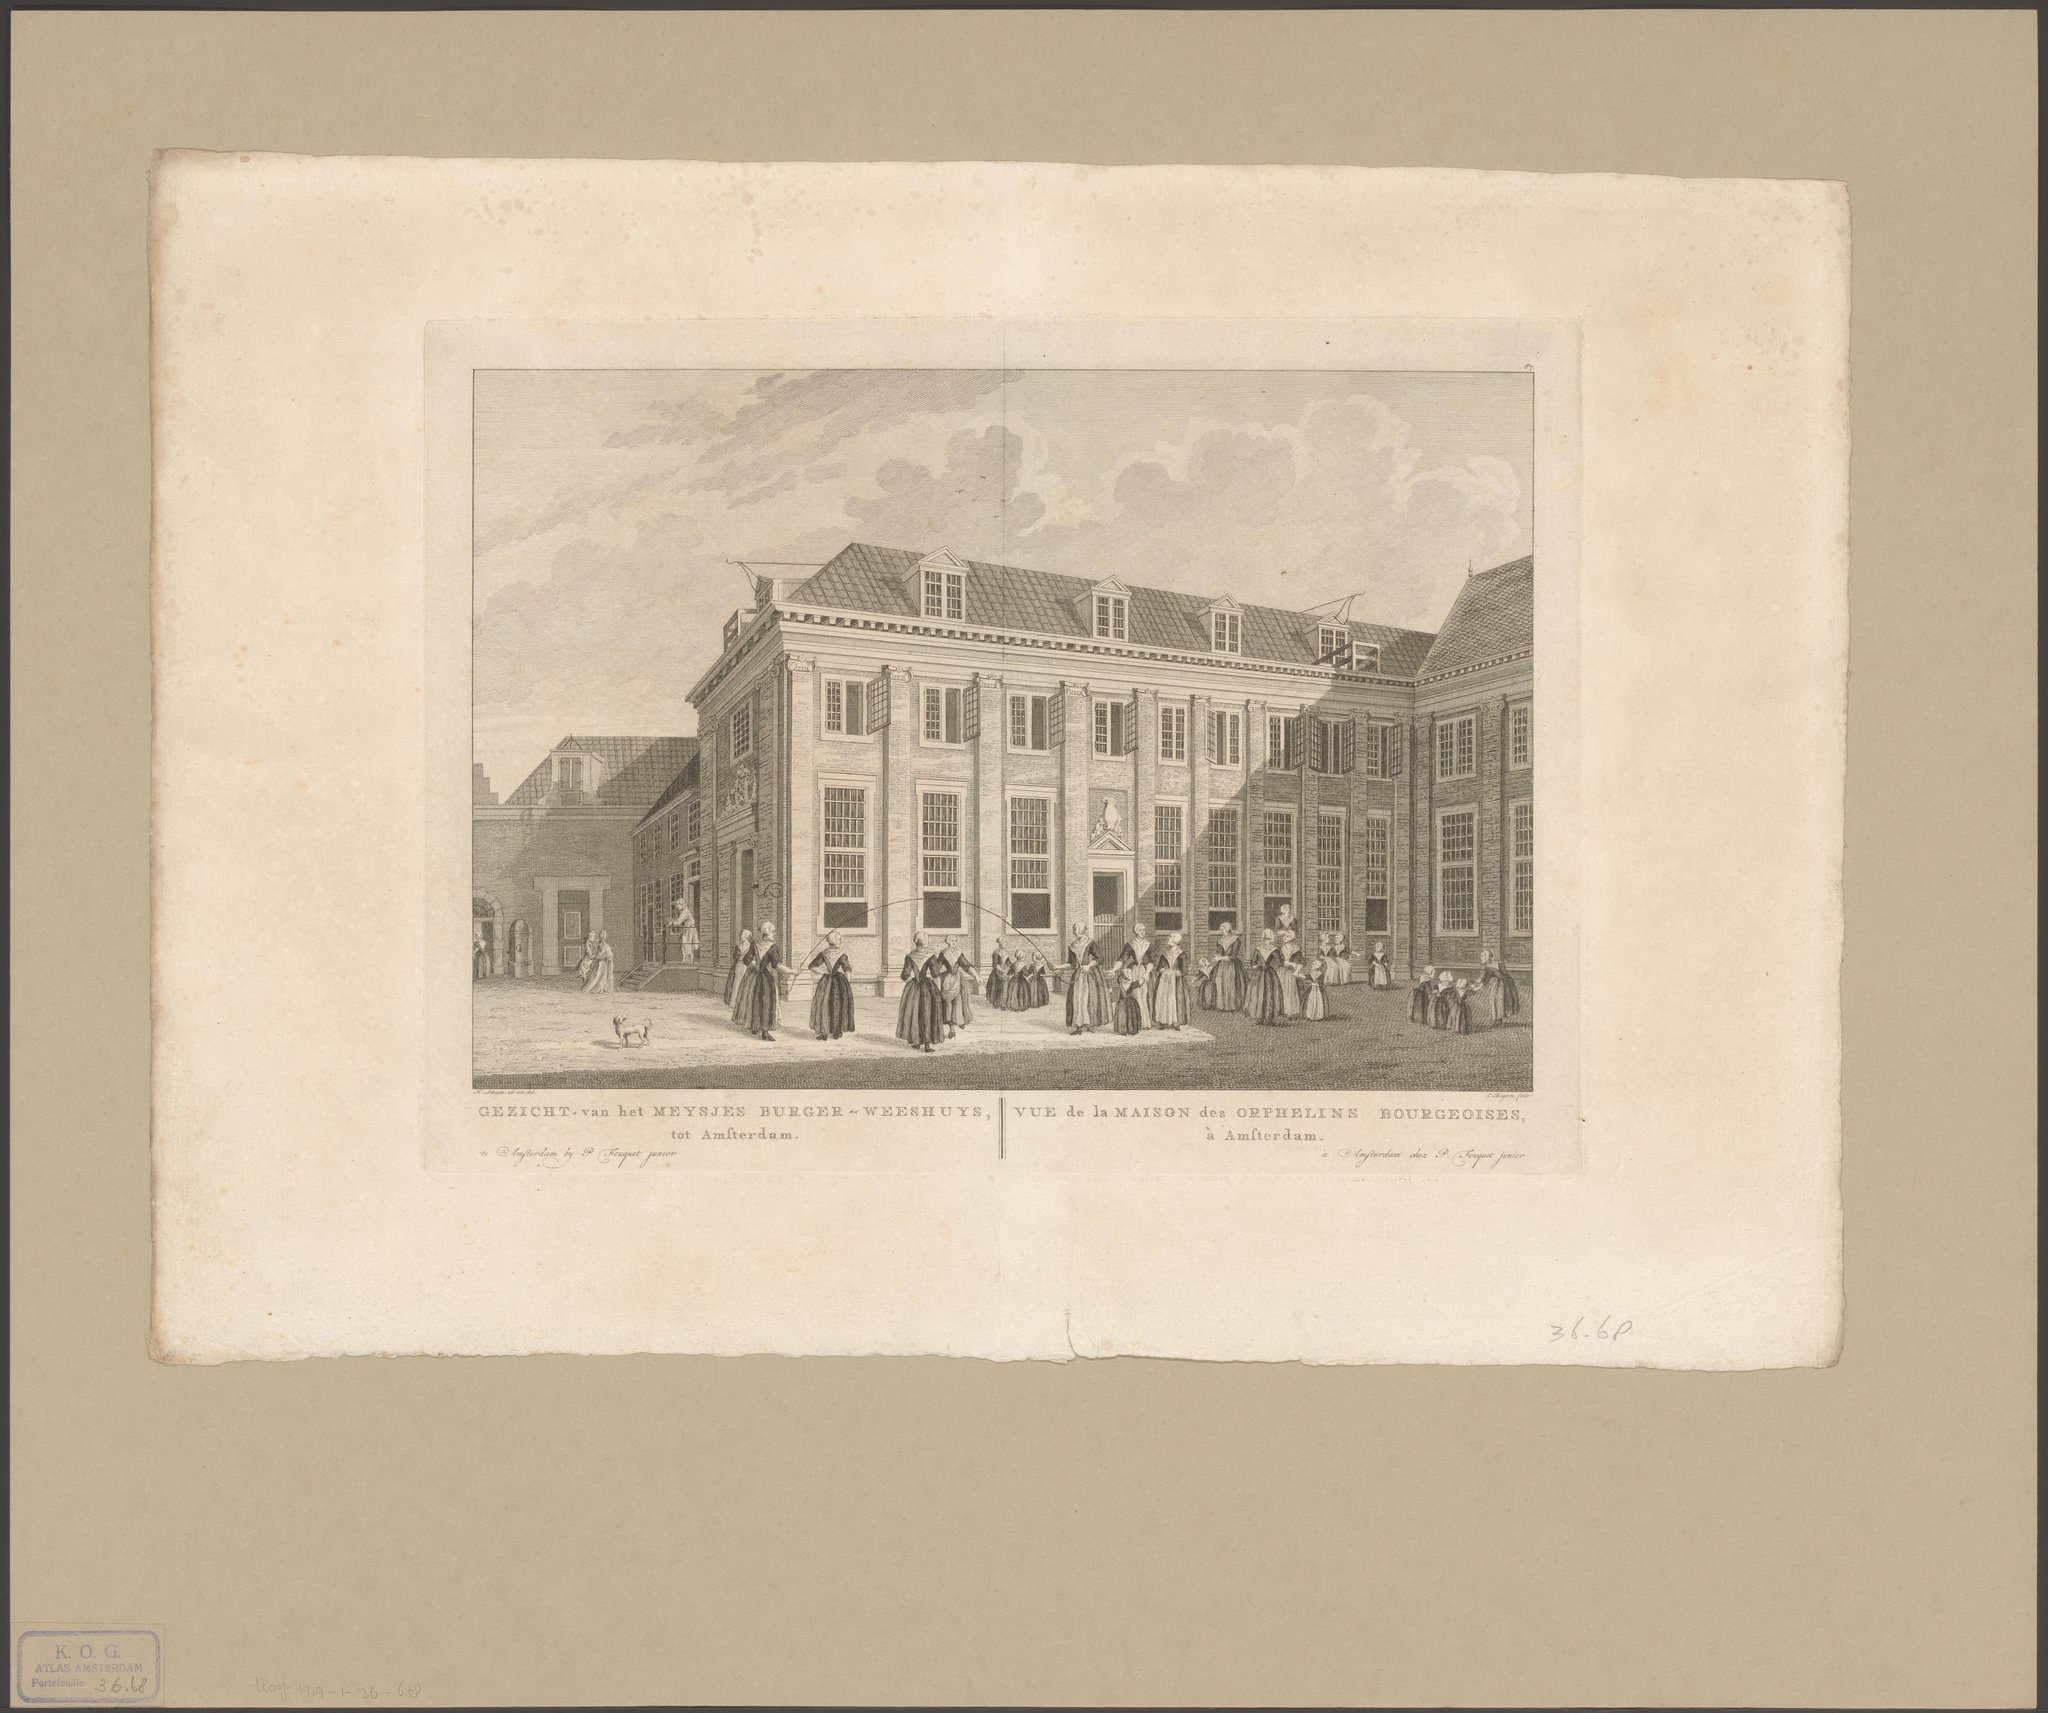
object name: print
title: Gezicht van het Meysjes Burger-weeshuys, in Amsterdam / Vue de la Maison des orphelins bourgeoises, à Amsterdam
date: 1770-1783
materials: paper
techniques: engraving, etching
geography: amsterdam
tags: public welfare, courtyard, orphanage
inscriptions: collector's mark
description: Gezicht op het meisjeshuis van het Burgerweeshuis te Amsterdam. Op de binnenplaats vele wezen in hun kenmerkende tweekleurige kleding en enkele andere figuren. Onder de voorstelling de titel in het Nederlands en Frans. Rechtsboven genummerd: 67. Onderwerpsrubriek binnen de Atlas Amsterdam: Armwezen en liefdadige instellingen: I. Stadsinrichtingen: Burgerweeshuis.